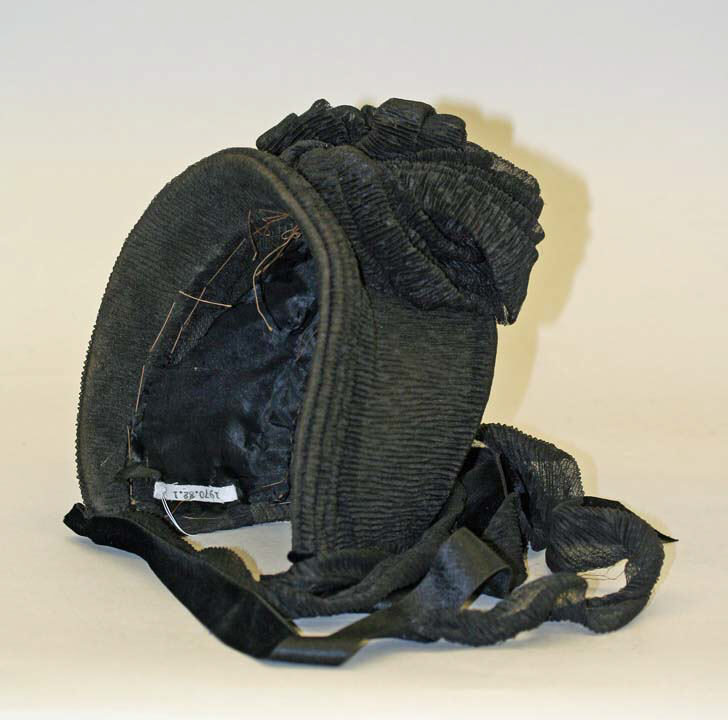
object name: bonnet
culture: american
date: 1880-1889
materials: silk